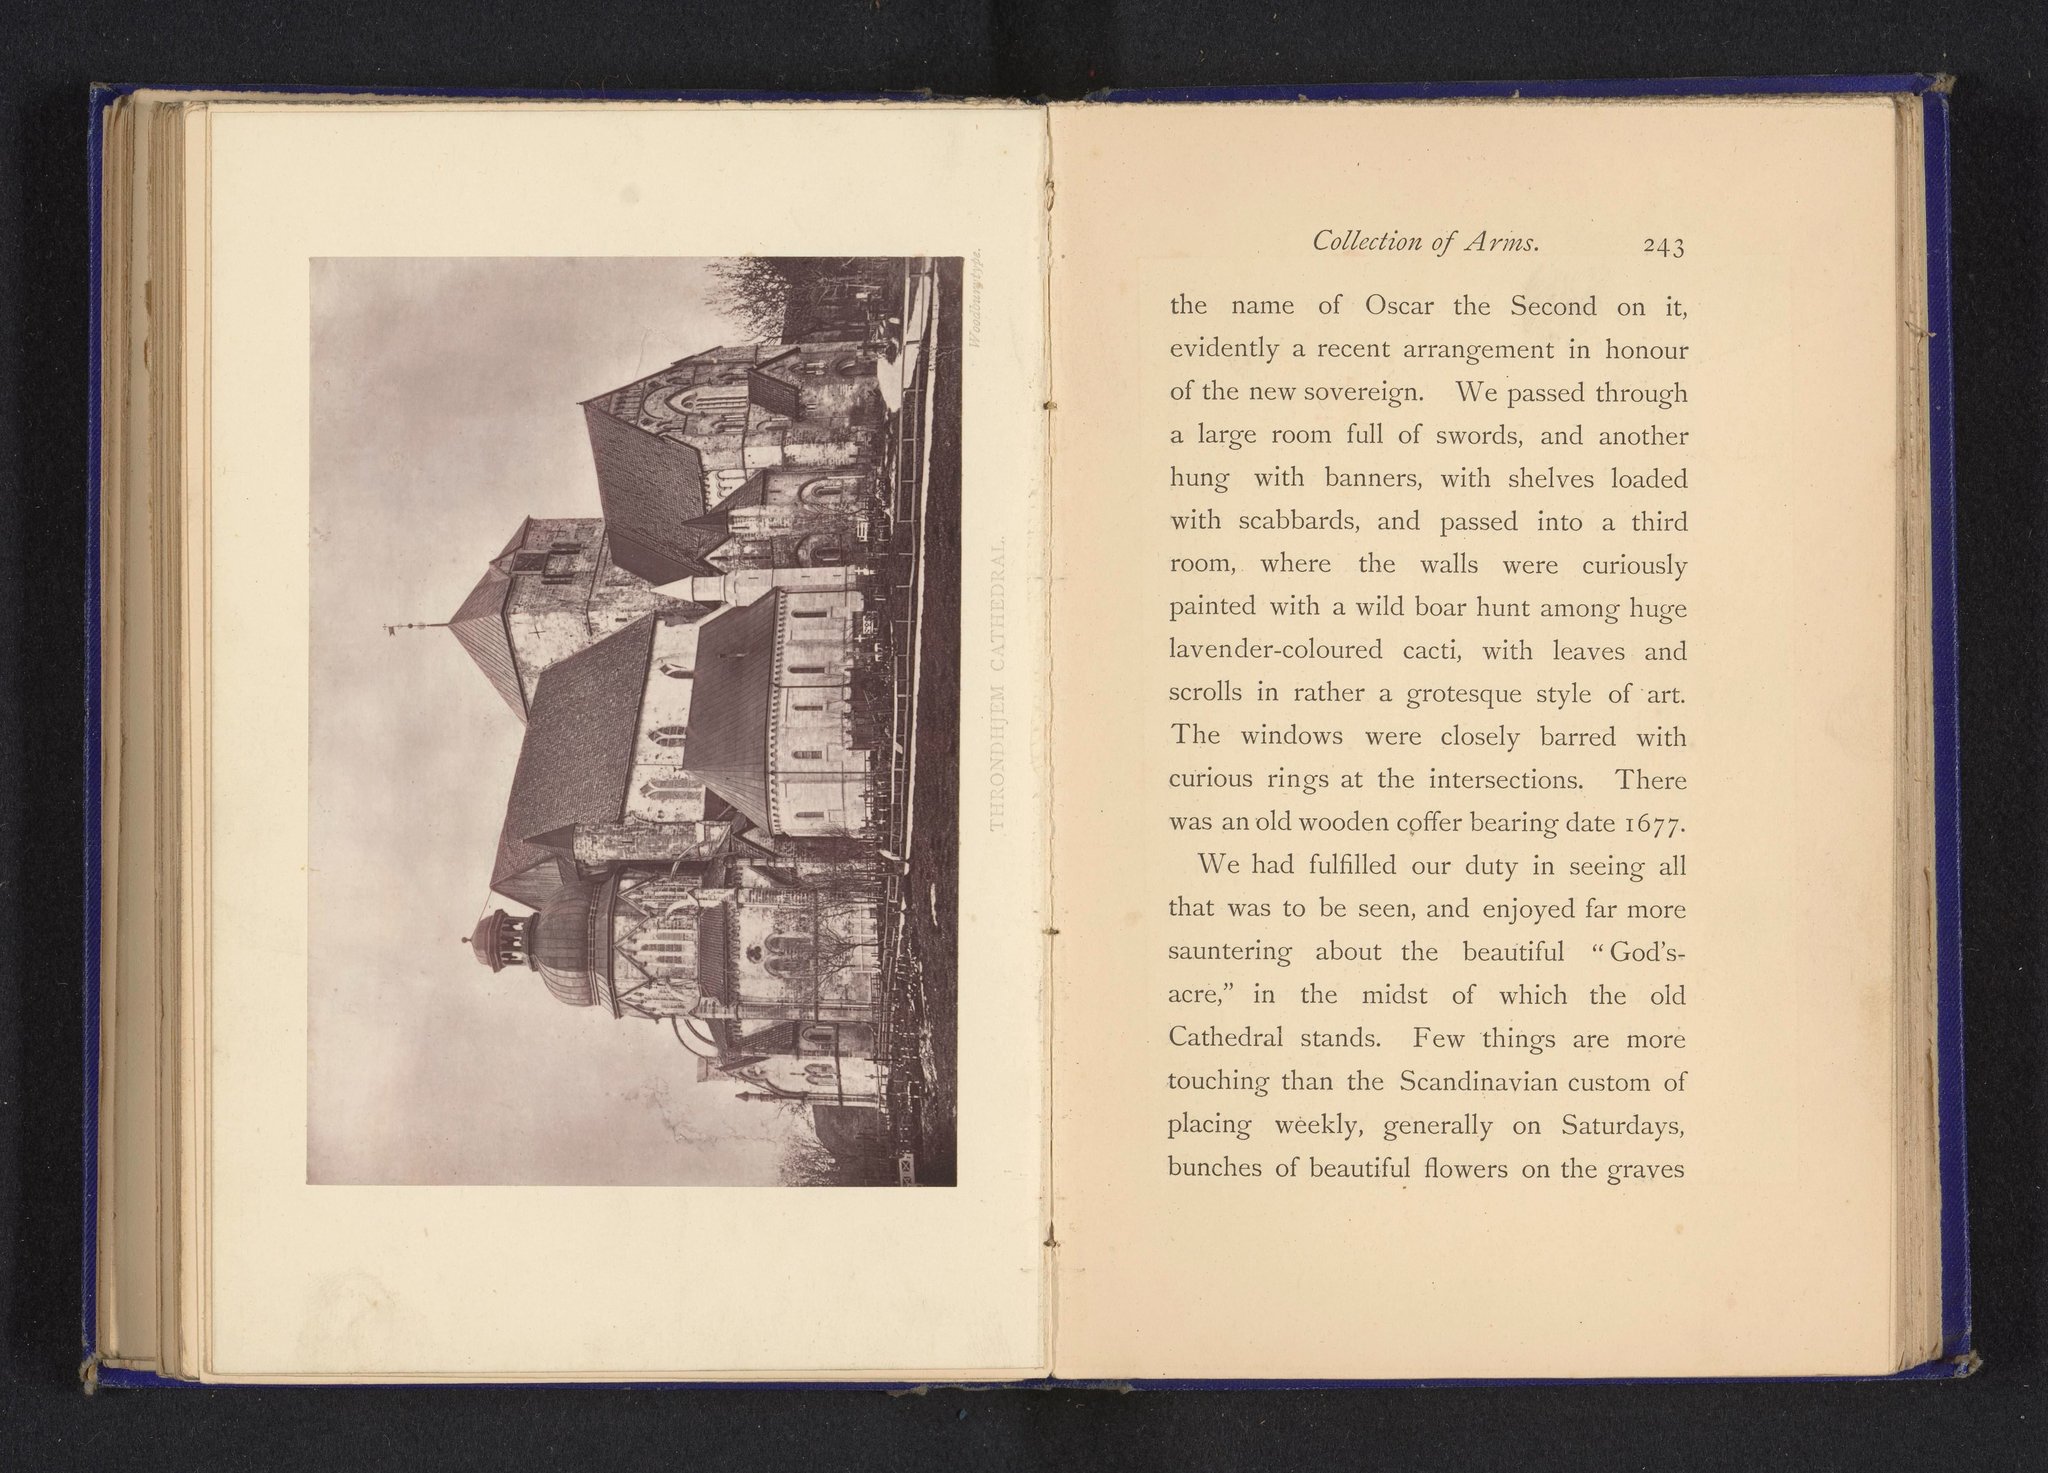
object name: photomechanical print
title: Throndhjem Cathedral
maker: Anonymous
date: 1872-1877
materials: paper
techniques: woodburytype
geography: trondheim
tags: church (exterior), façade (of house or building)